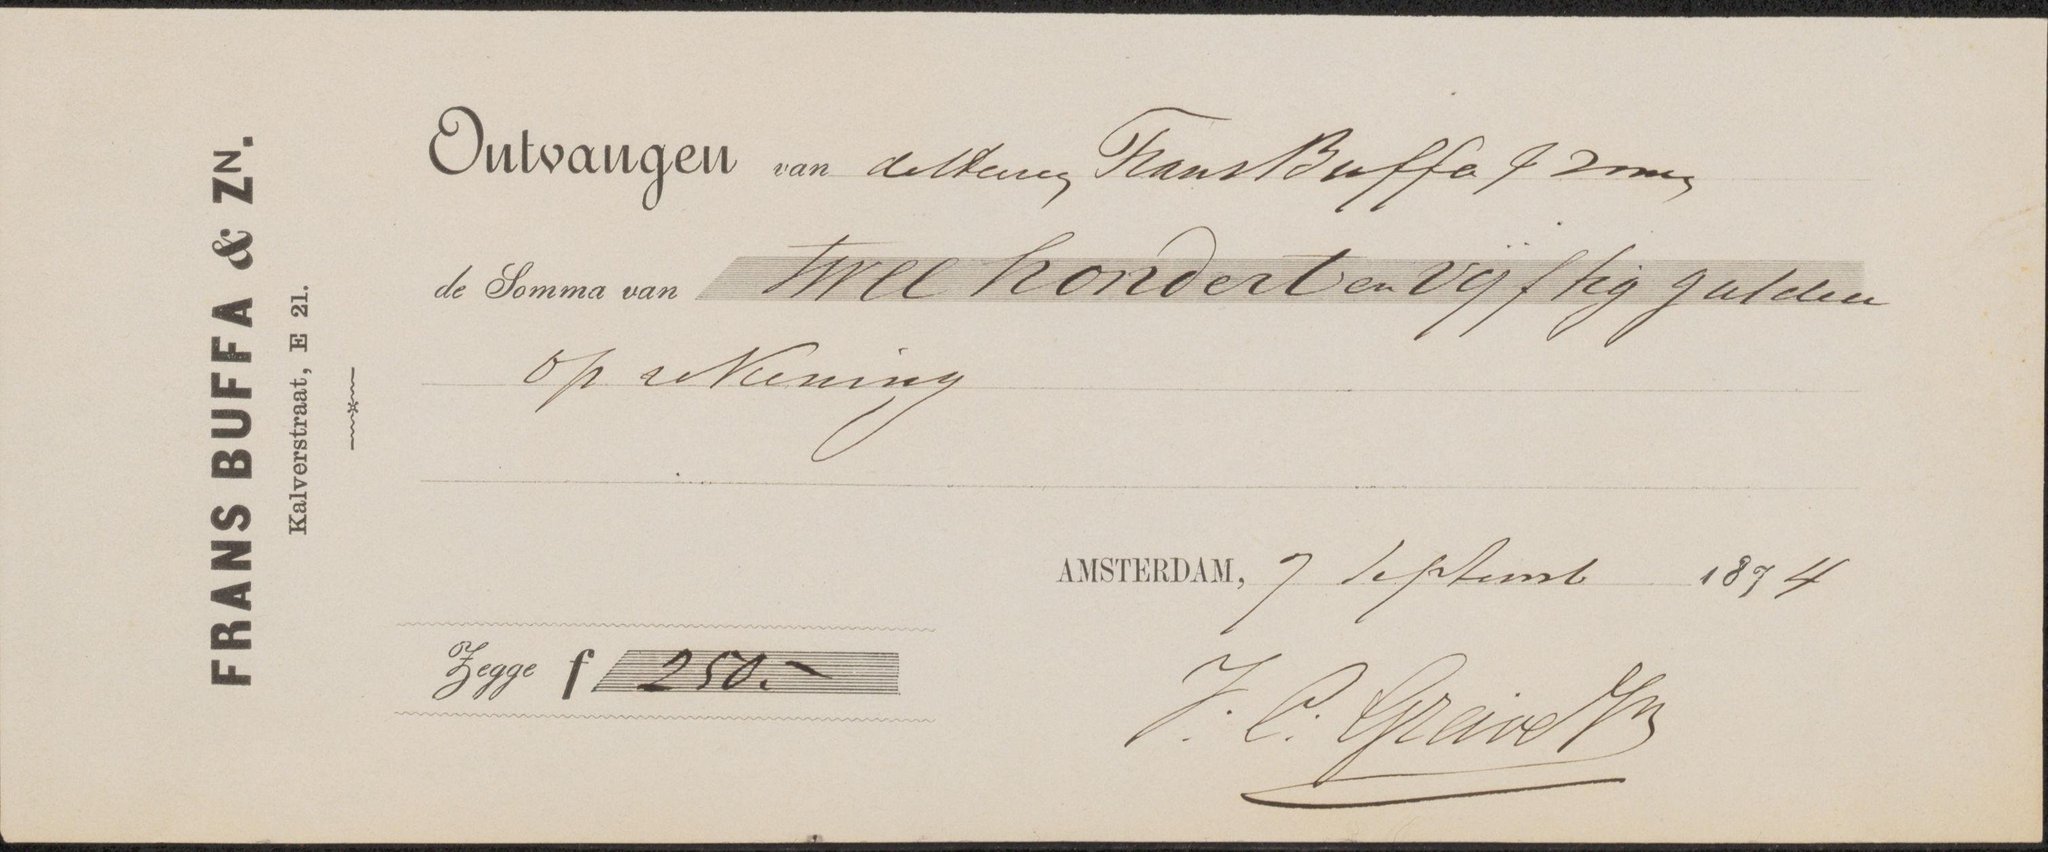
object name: ontvangstbewijs, kwitantie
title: Kwitantie voor Johan Conrad Greive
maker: johan conrad greive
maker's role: draughtsman, painter, print maker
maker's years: 1837-1891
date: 1874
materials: ink, paper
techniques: pen, printing, writing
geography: amsterdam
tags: amsterdam, painter, draughtsman, johan conrad greive, money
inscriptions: collector's mark: Lugt 2233